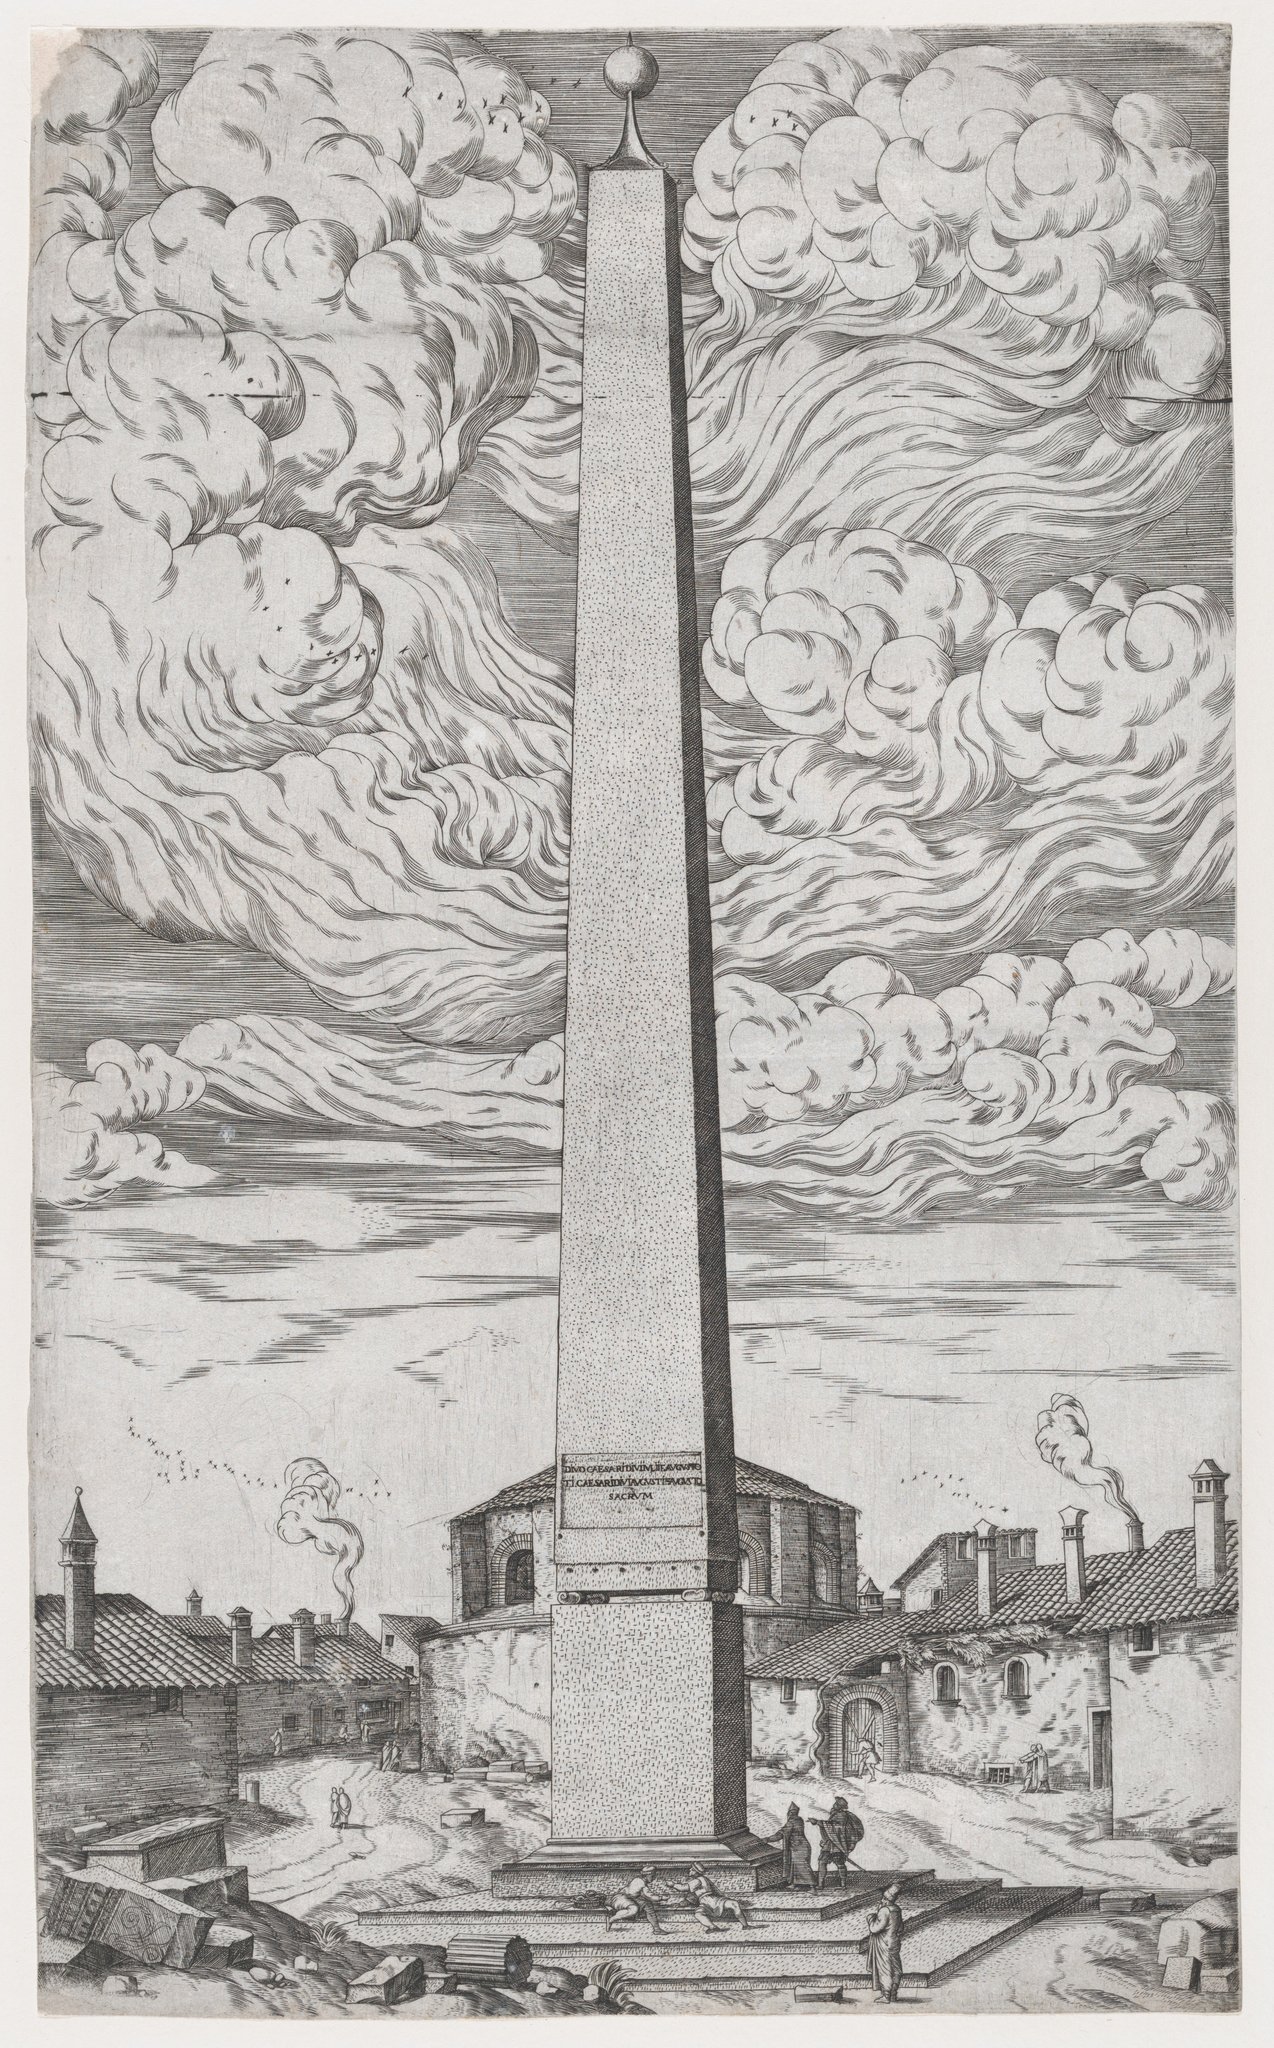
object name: print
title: The Vatican Obelisk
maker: anonymous, italian, 16th century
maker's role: artist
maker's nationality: italian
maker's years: 1500-1600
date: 1501-1600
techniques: engraving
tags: obelisks,rome